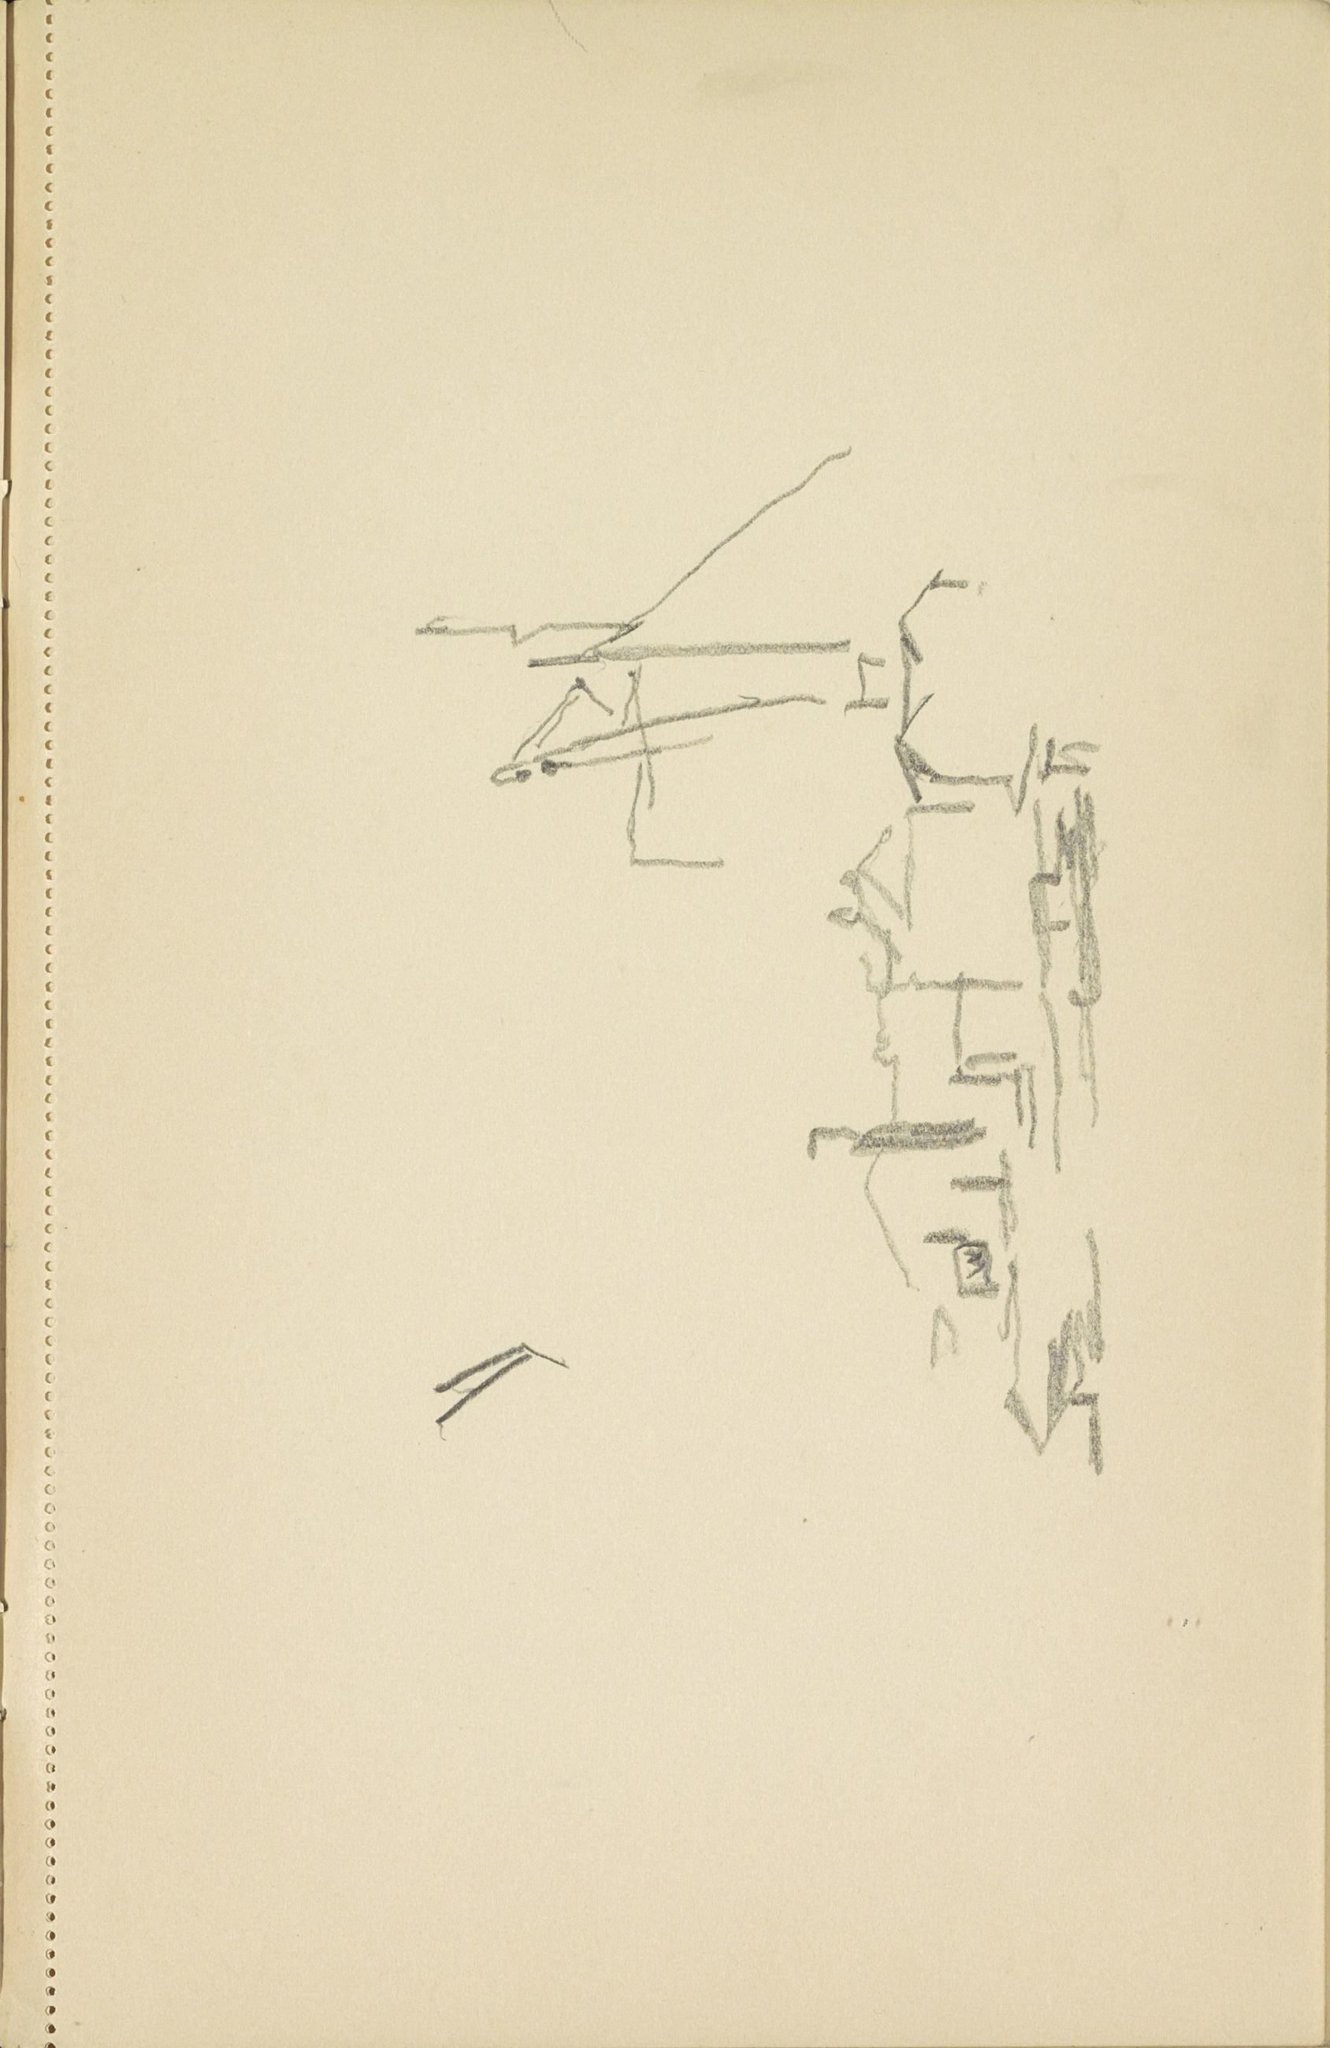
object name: sketchbook leaf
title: Rij huizen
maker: cornelis vreedenburgh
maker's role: draughtsman, print maker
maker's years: 1880-1946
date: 1890-1946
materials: paper, pencil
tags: housing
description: Blad 52 recto uit een schetsboek met 73 bladen.